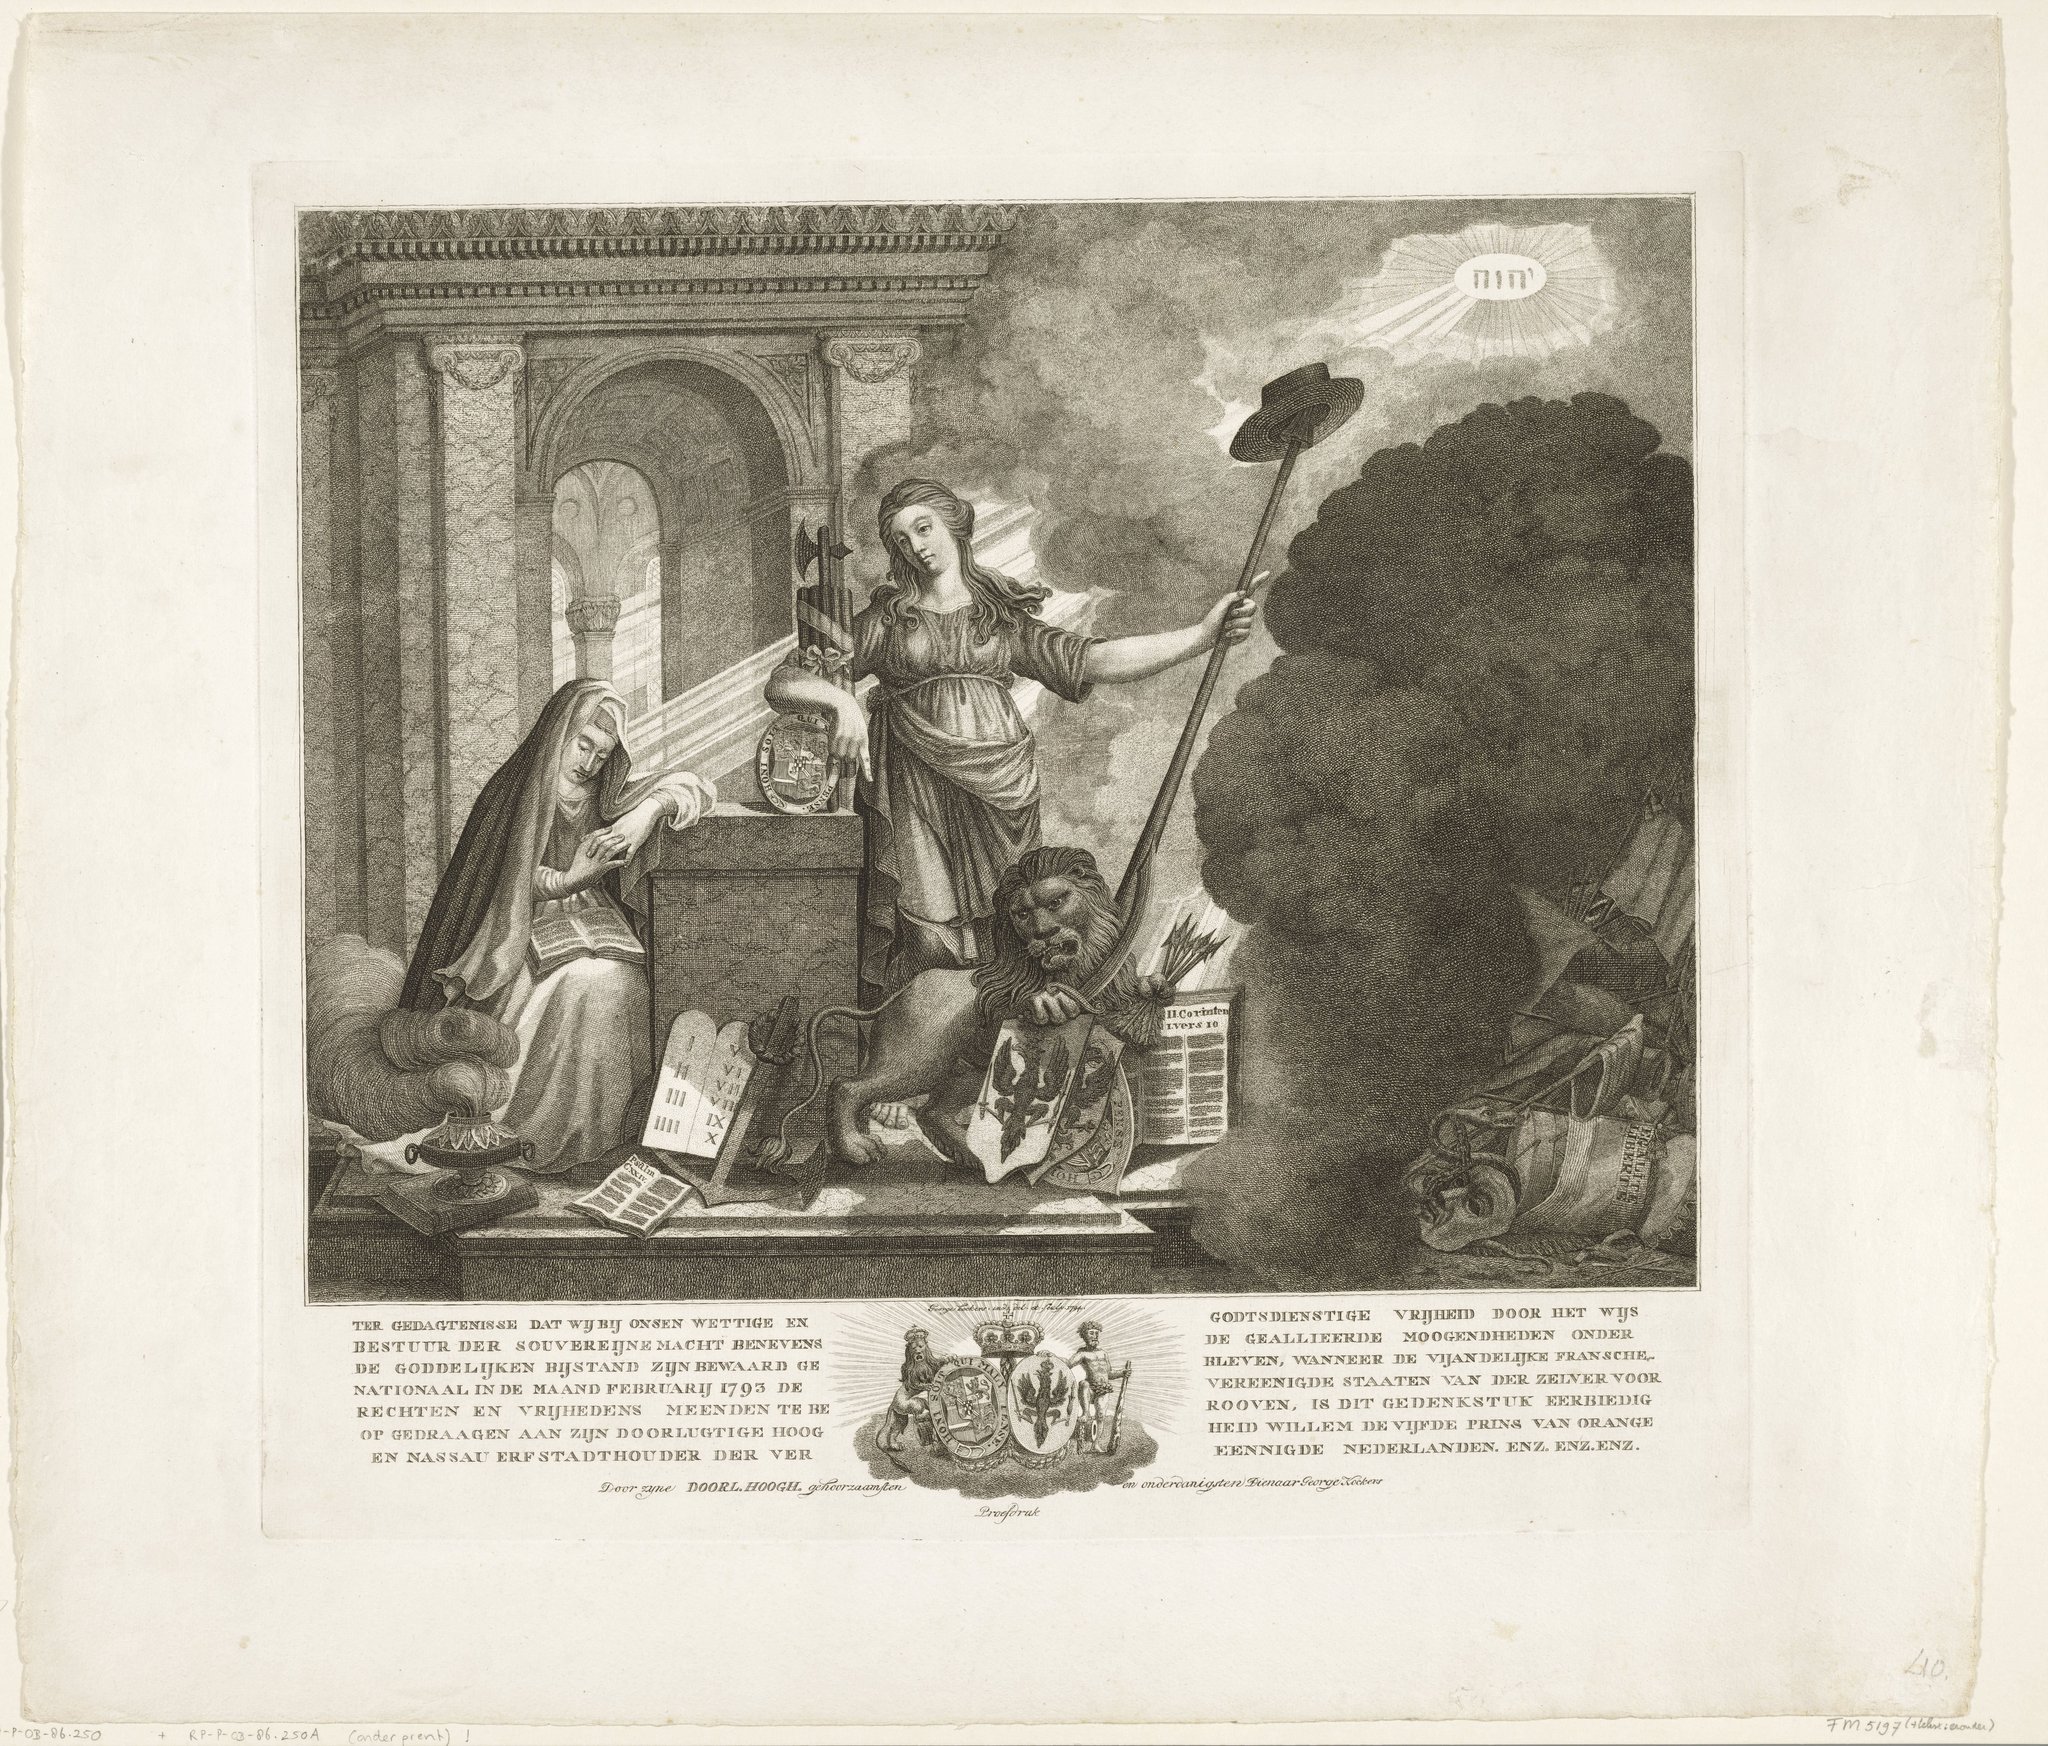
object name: print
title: Allegorie op het behoud van de vrijheid tegenover de Franse vijand, 1793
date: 1794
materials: paper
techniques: engraving, etching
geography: northern netherlands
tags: the hague, william v (prince of orange), allegorical representations ~ religion; 'religione', 'religione de ss. mauritio e lazaro', 'religione vera christiana' (ripa), freedom, liberty; 'libertà' (ripa) (+ abstract concept represented by female figure)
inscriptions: collector's mark: Lugt 2228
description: Allegorie op het behoud van de vrijheid en godsdienst in de Republiek, dankzij de steun van God en de Coalitietroepen, door de overwinning op de Franse troepen in februari 1793. Godsdienst, de Nederlandse Maagd met vrijheidslans en de Nederlandse leeuw bij een altaar. Rechts in een donkere wolk Franse wapens, masker en een vaandel gemerkt 'Egalite Liberte'. Onderaan de wapens van de stadhouder en van Oostenrijk. Bij de plaat behoort een tekstblad.